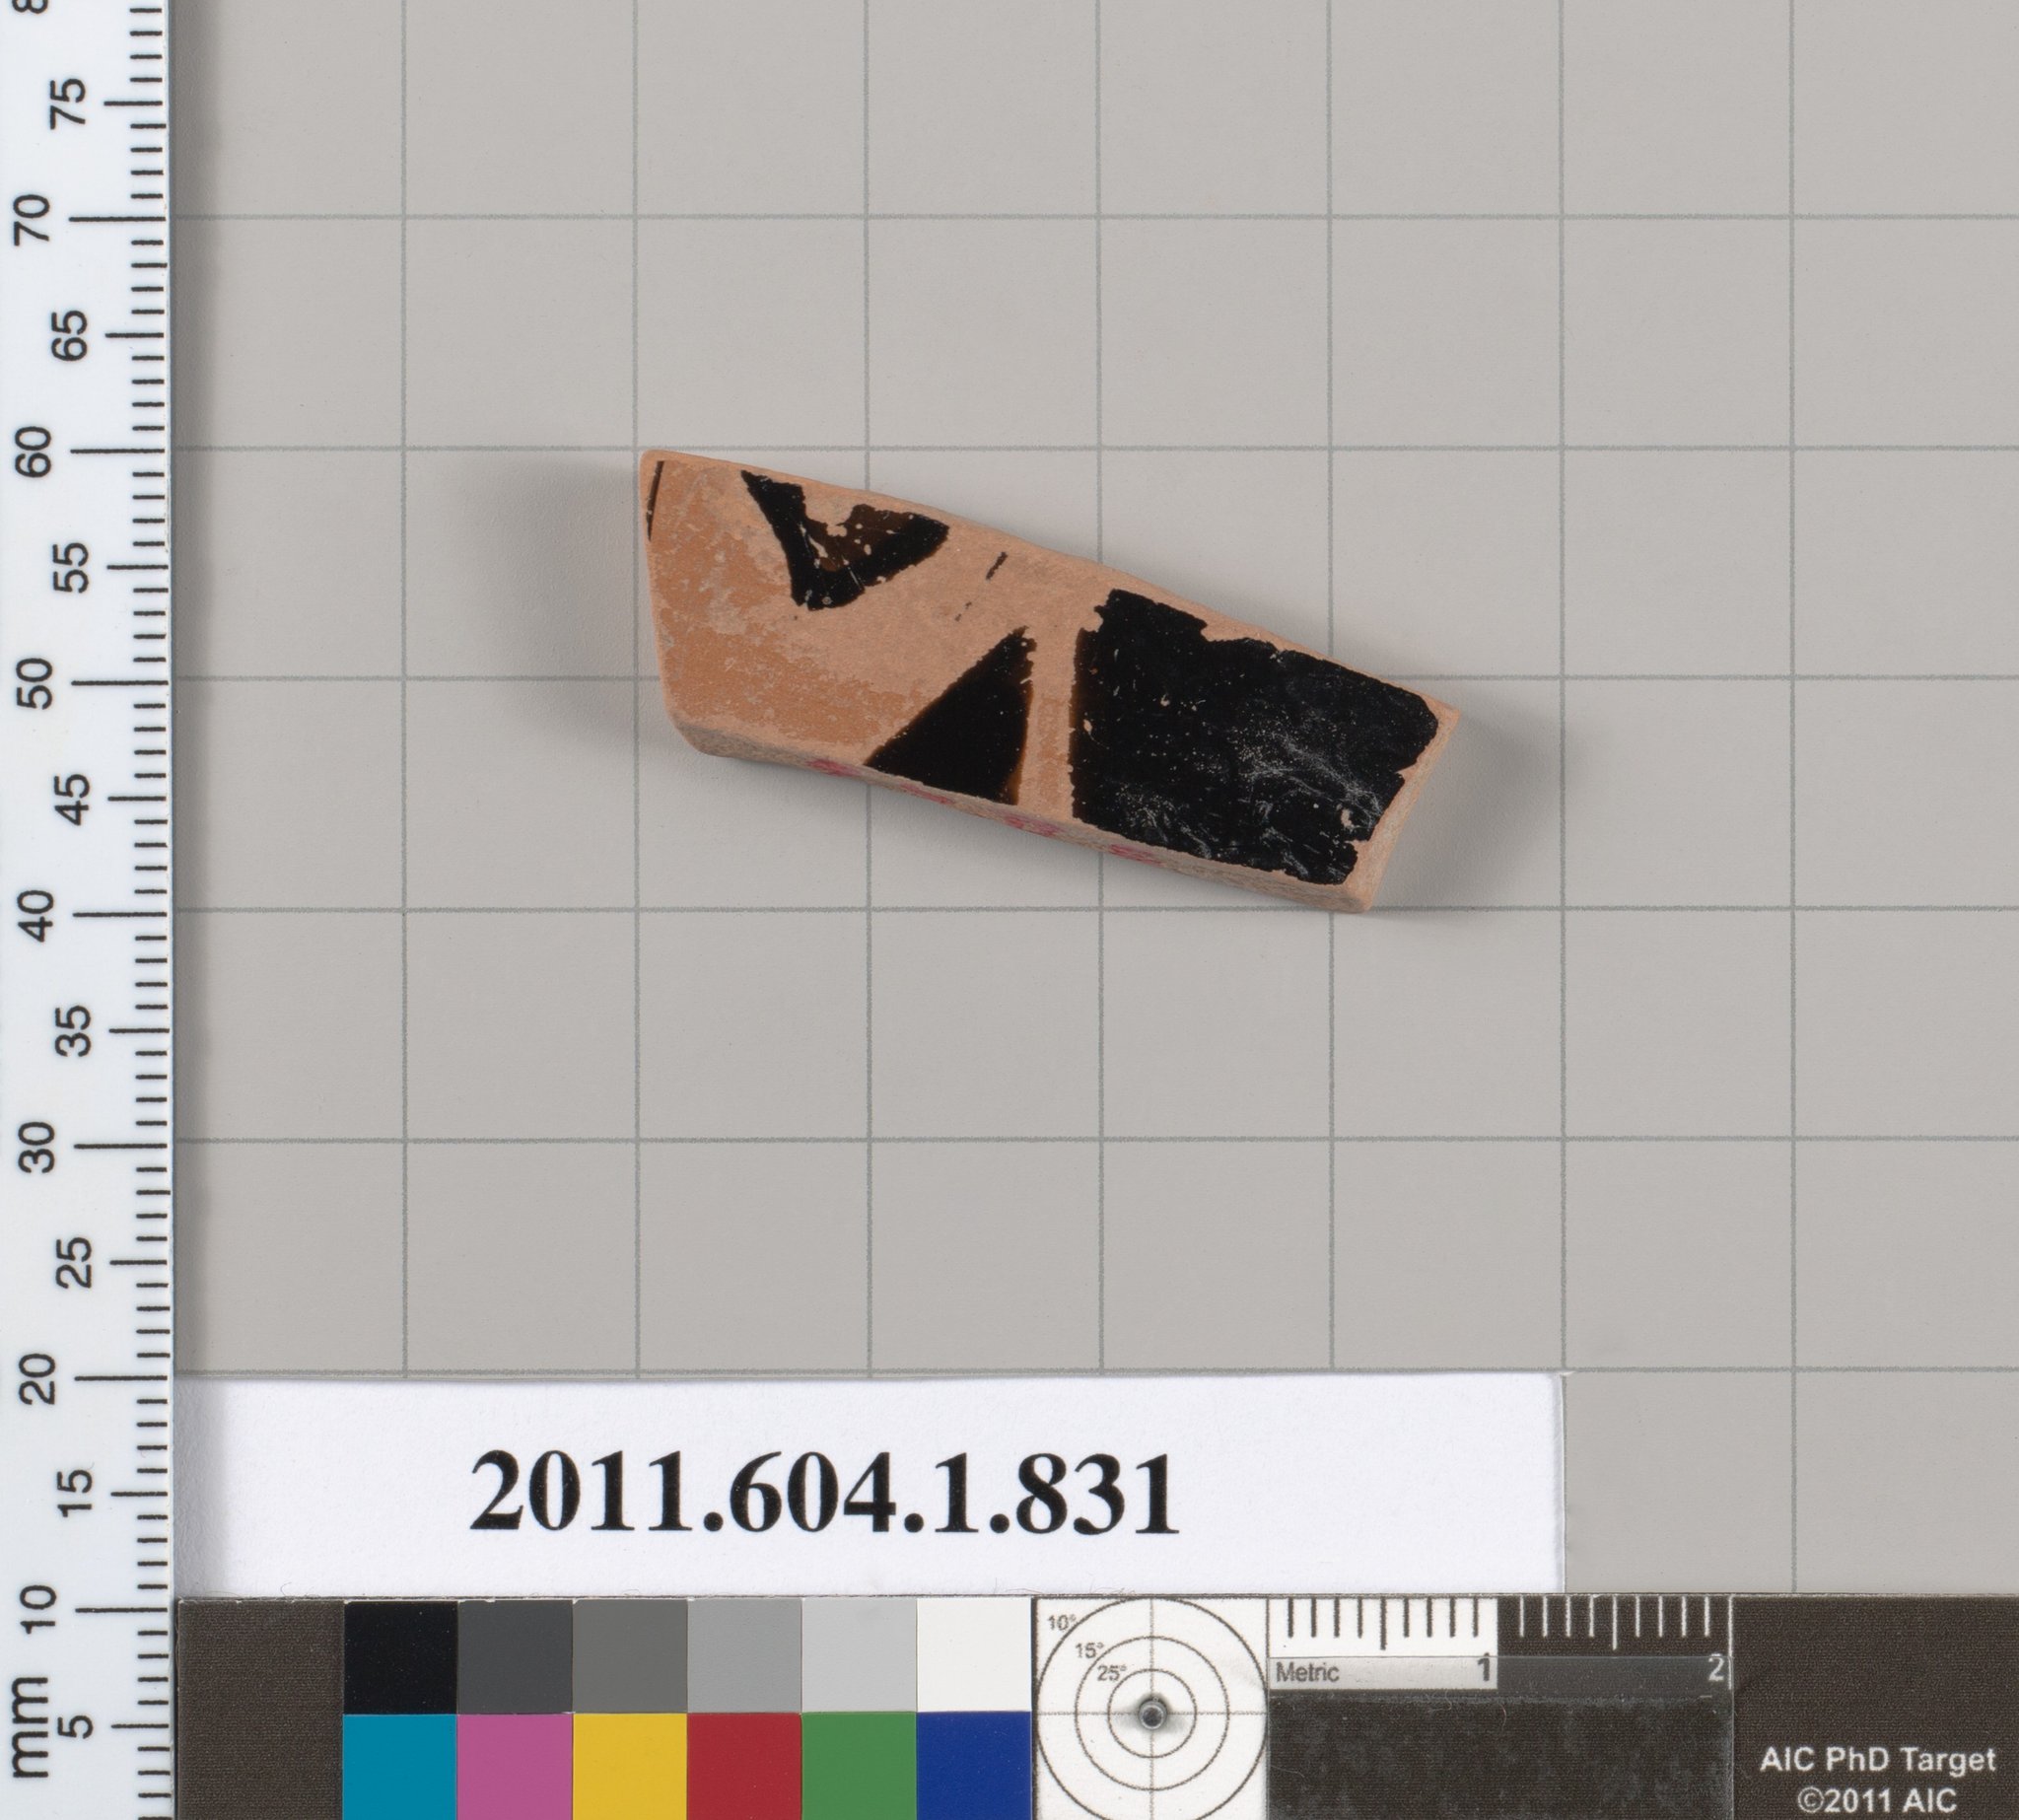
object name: kylix fragment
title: Terracotta fragment of a kylix (drinking cup)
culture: greek, attic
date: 475-451 BCE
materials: terracotta